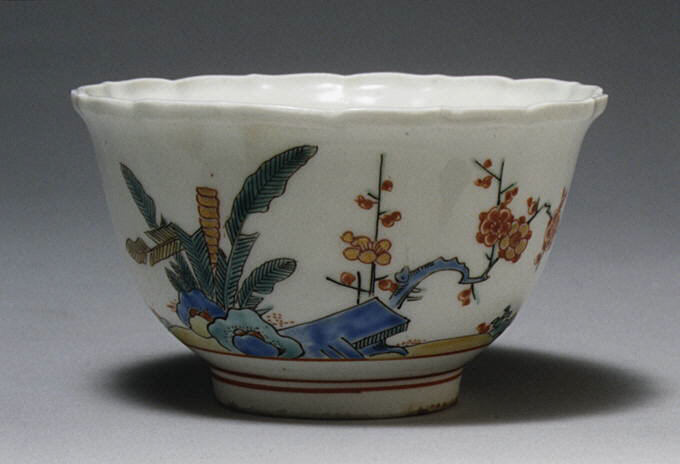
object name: bowl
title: Pair of bowls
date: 1720-1730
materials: hard paste porcelain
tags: flowers